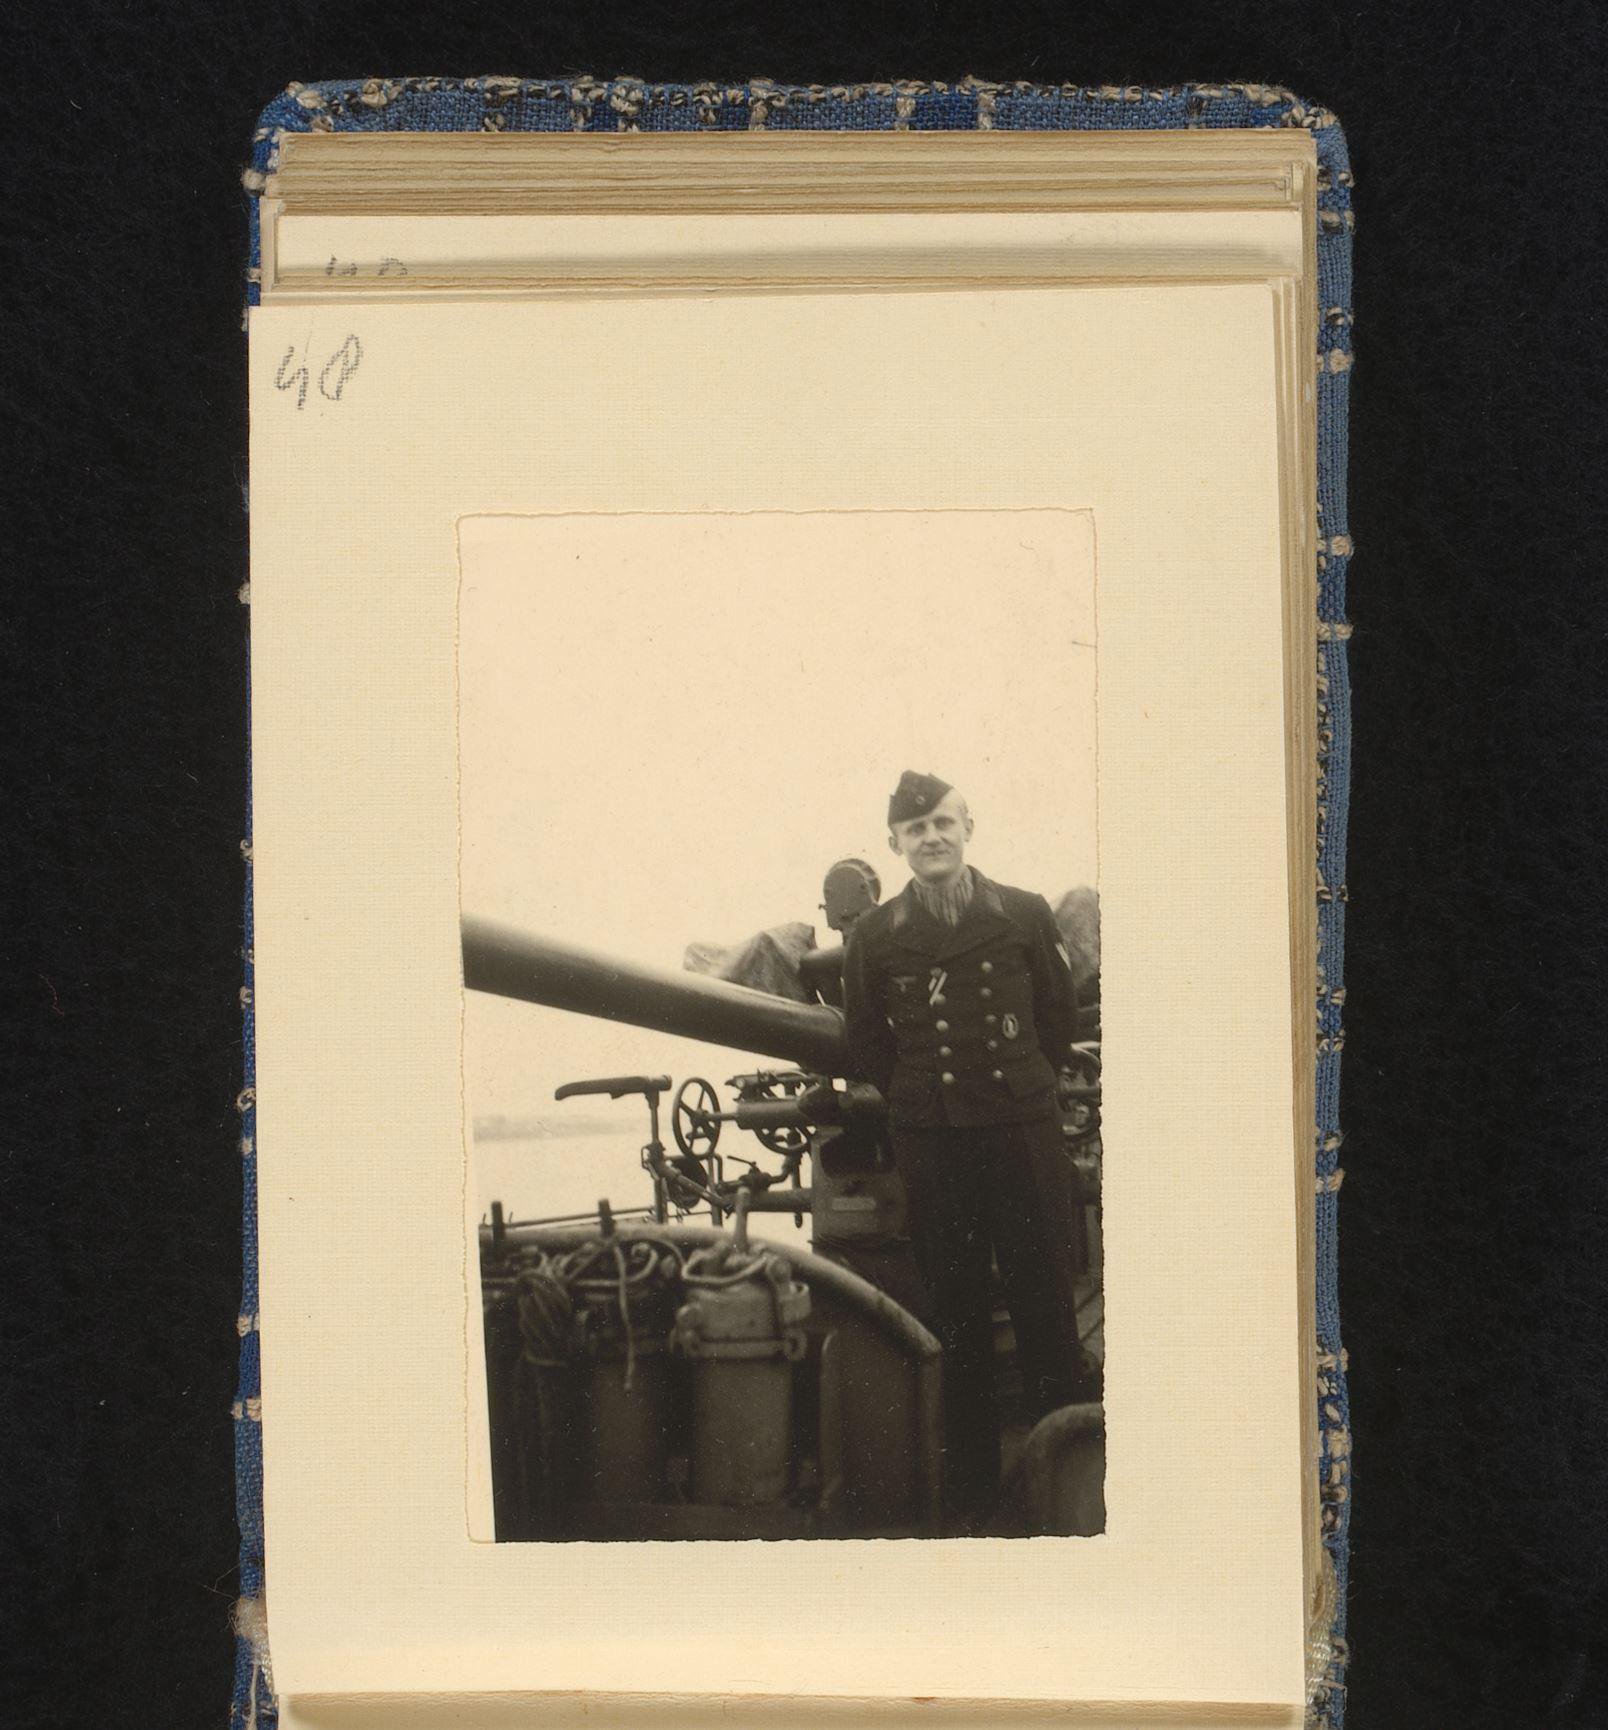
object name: photograph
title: Matroos aan boord van zijn schip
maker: Anonymous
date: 1940-1943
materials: photographic support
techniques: gelatin silver print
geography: france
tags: the company, the unit, the troop ~ military service, sailor, netherlands, france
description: Een Duitse matroos in uniform aan boord van zijn schip. Hij poseert naast de loop van een kanon. Waarschijnlijk is dit de samensteller van het album. Onderdeel van het fotoalbum over de Kriegsmarine 1940-1943.